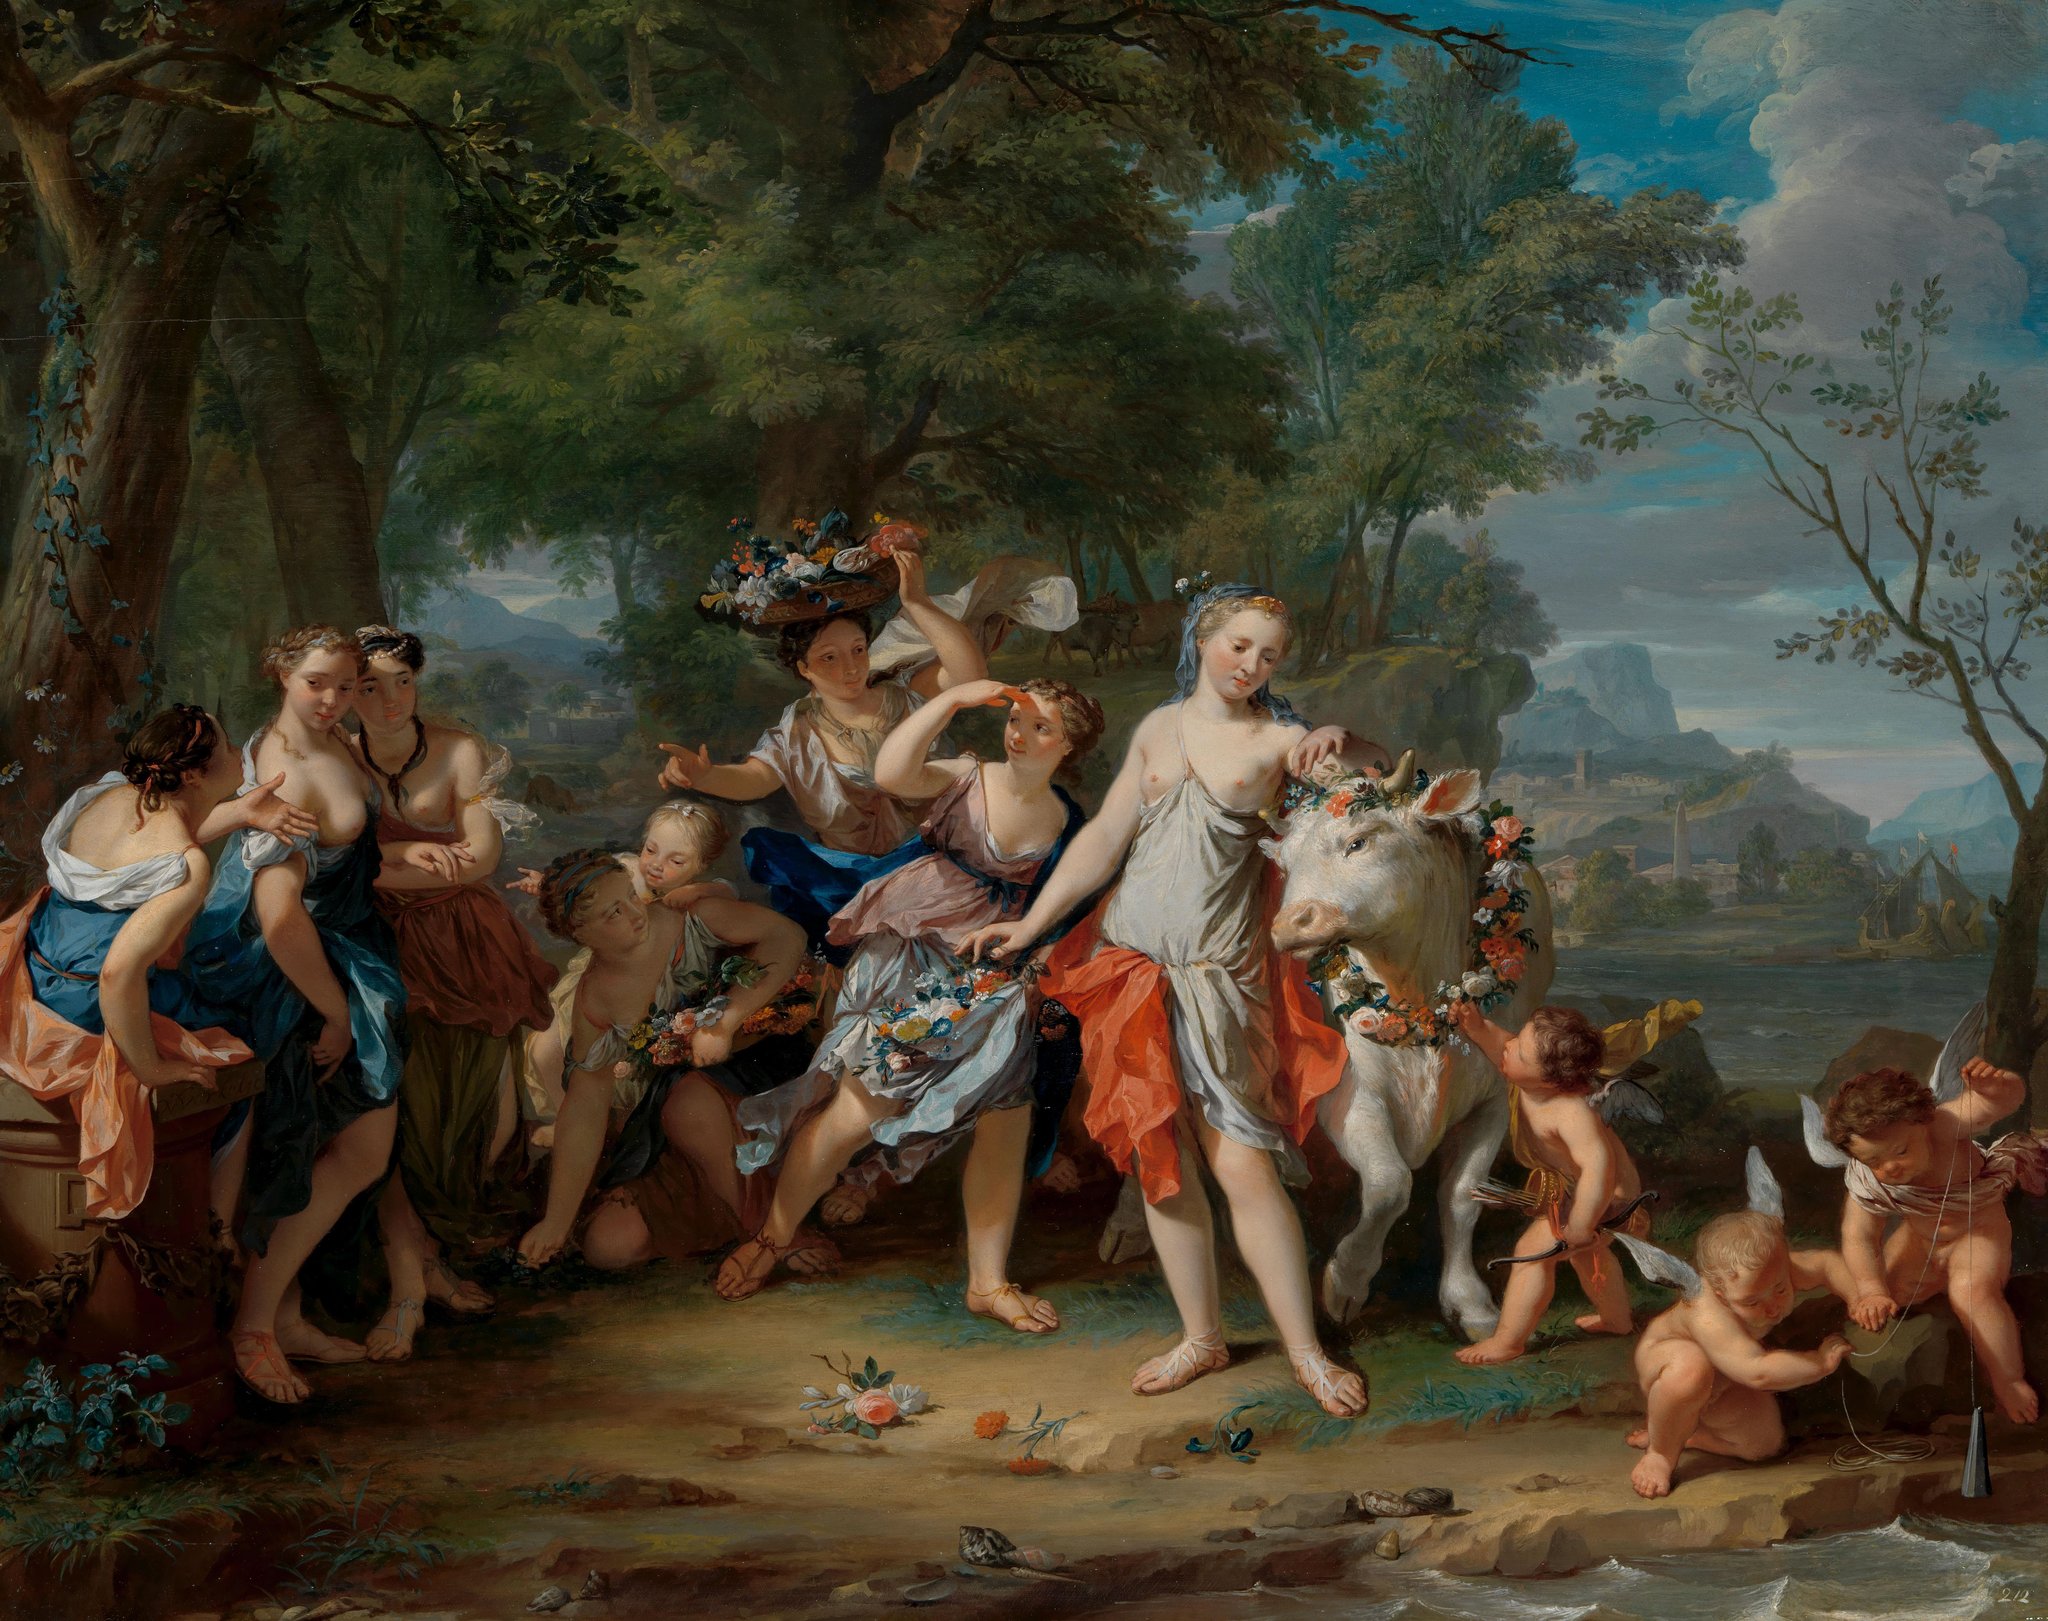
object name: painting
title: The Rape of Europa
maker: nicolaas verkolje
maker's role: draughtsman, painter, print maker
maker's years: 1673-1746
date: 1735-1740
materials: oil, panel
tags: europa and her maidens play with the bull, and/or adorn it with flowers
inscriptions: signature: ‘NVerkolje’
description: Zeus, the king of the gods, has disguised himself as a bull in order to seduce the chaste maiden Europa. To their right Cupid stands ready to shoot his arrows of love. In depicting this story from the Metamorphoses, the famous book by the Roman poet Ovid, Verkolje demonstrates his knowledge of Classical literature. Moreover, he proves his artistic virtuosity by means of the complex composition with numerous figures.